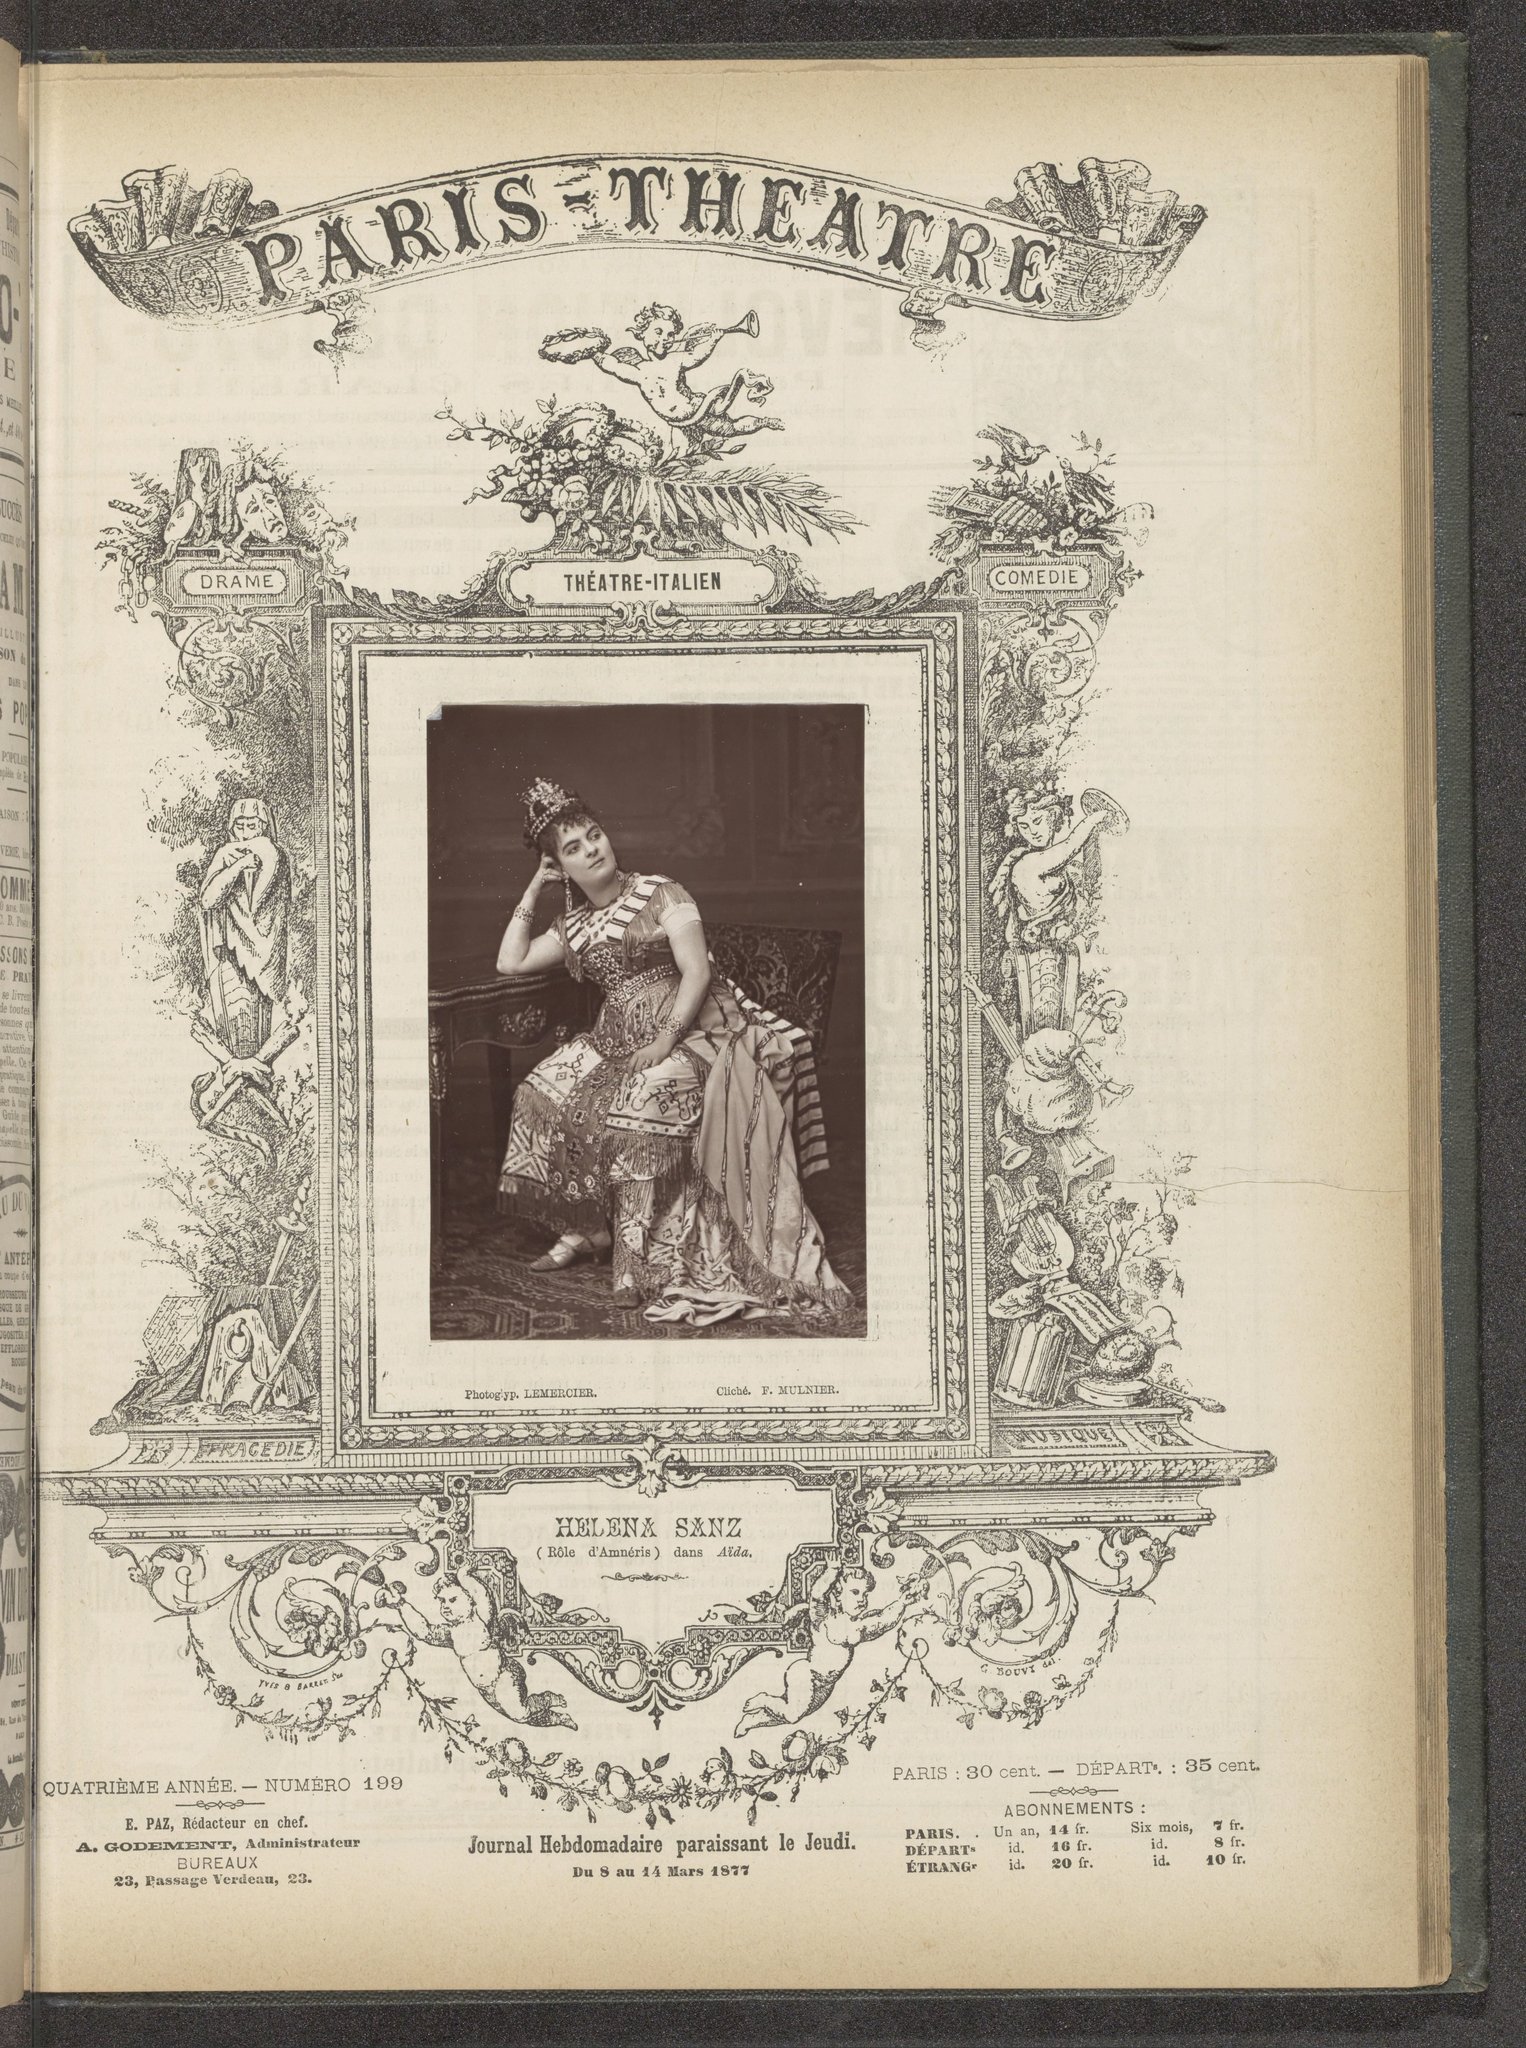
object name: photomechanical print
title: Helena Sanz (rôle d'Amnéris) dans Aïda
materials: paper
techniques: woodburytype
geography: france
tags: portrait of opera-singer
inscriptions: inscription: ‘Journal Hebdomadaire paraissant le Jeudi, Du 8 au 14 Mars 1877’, number: ‘Numéro 199’